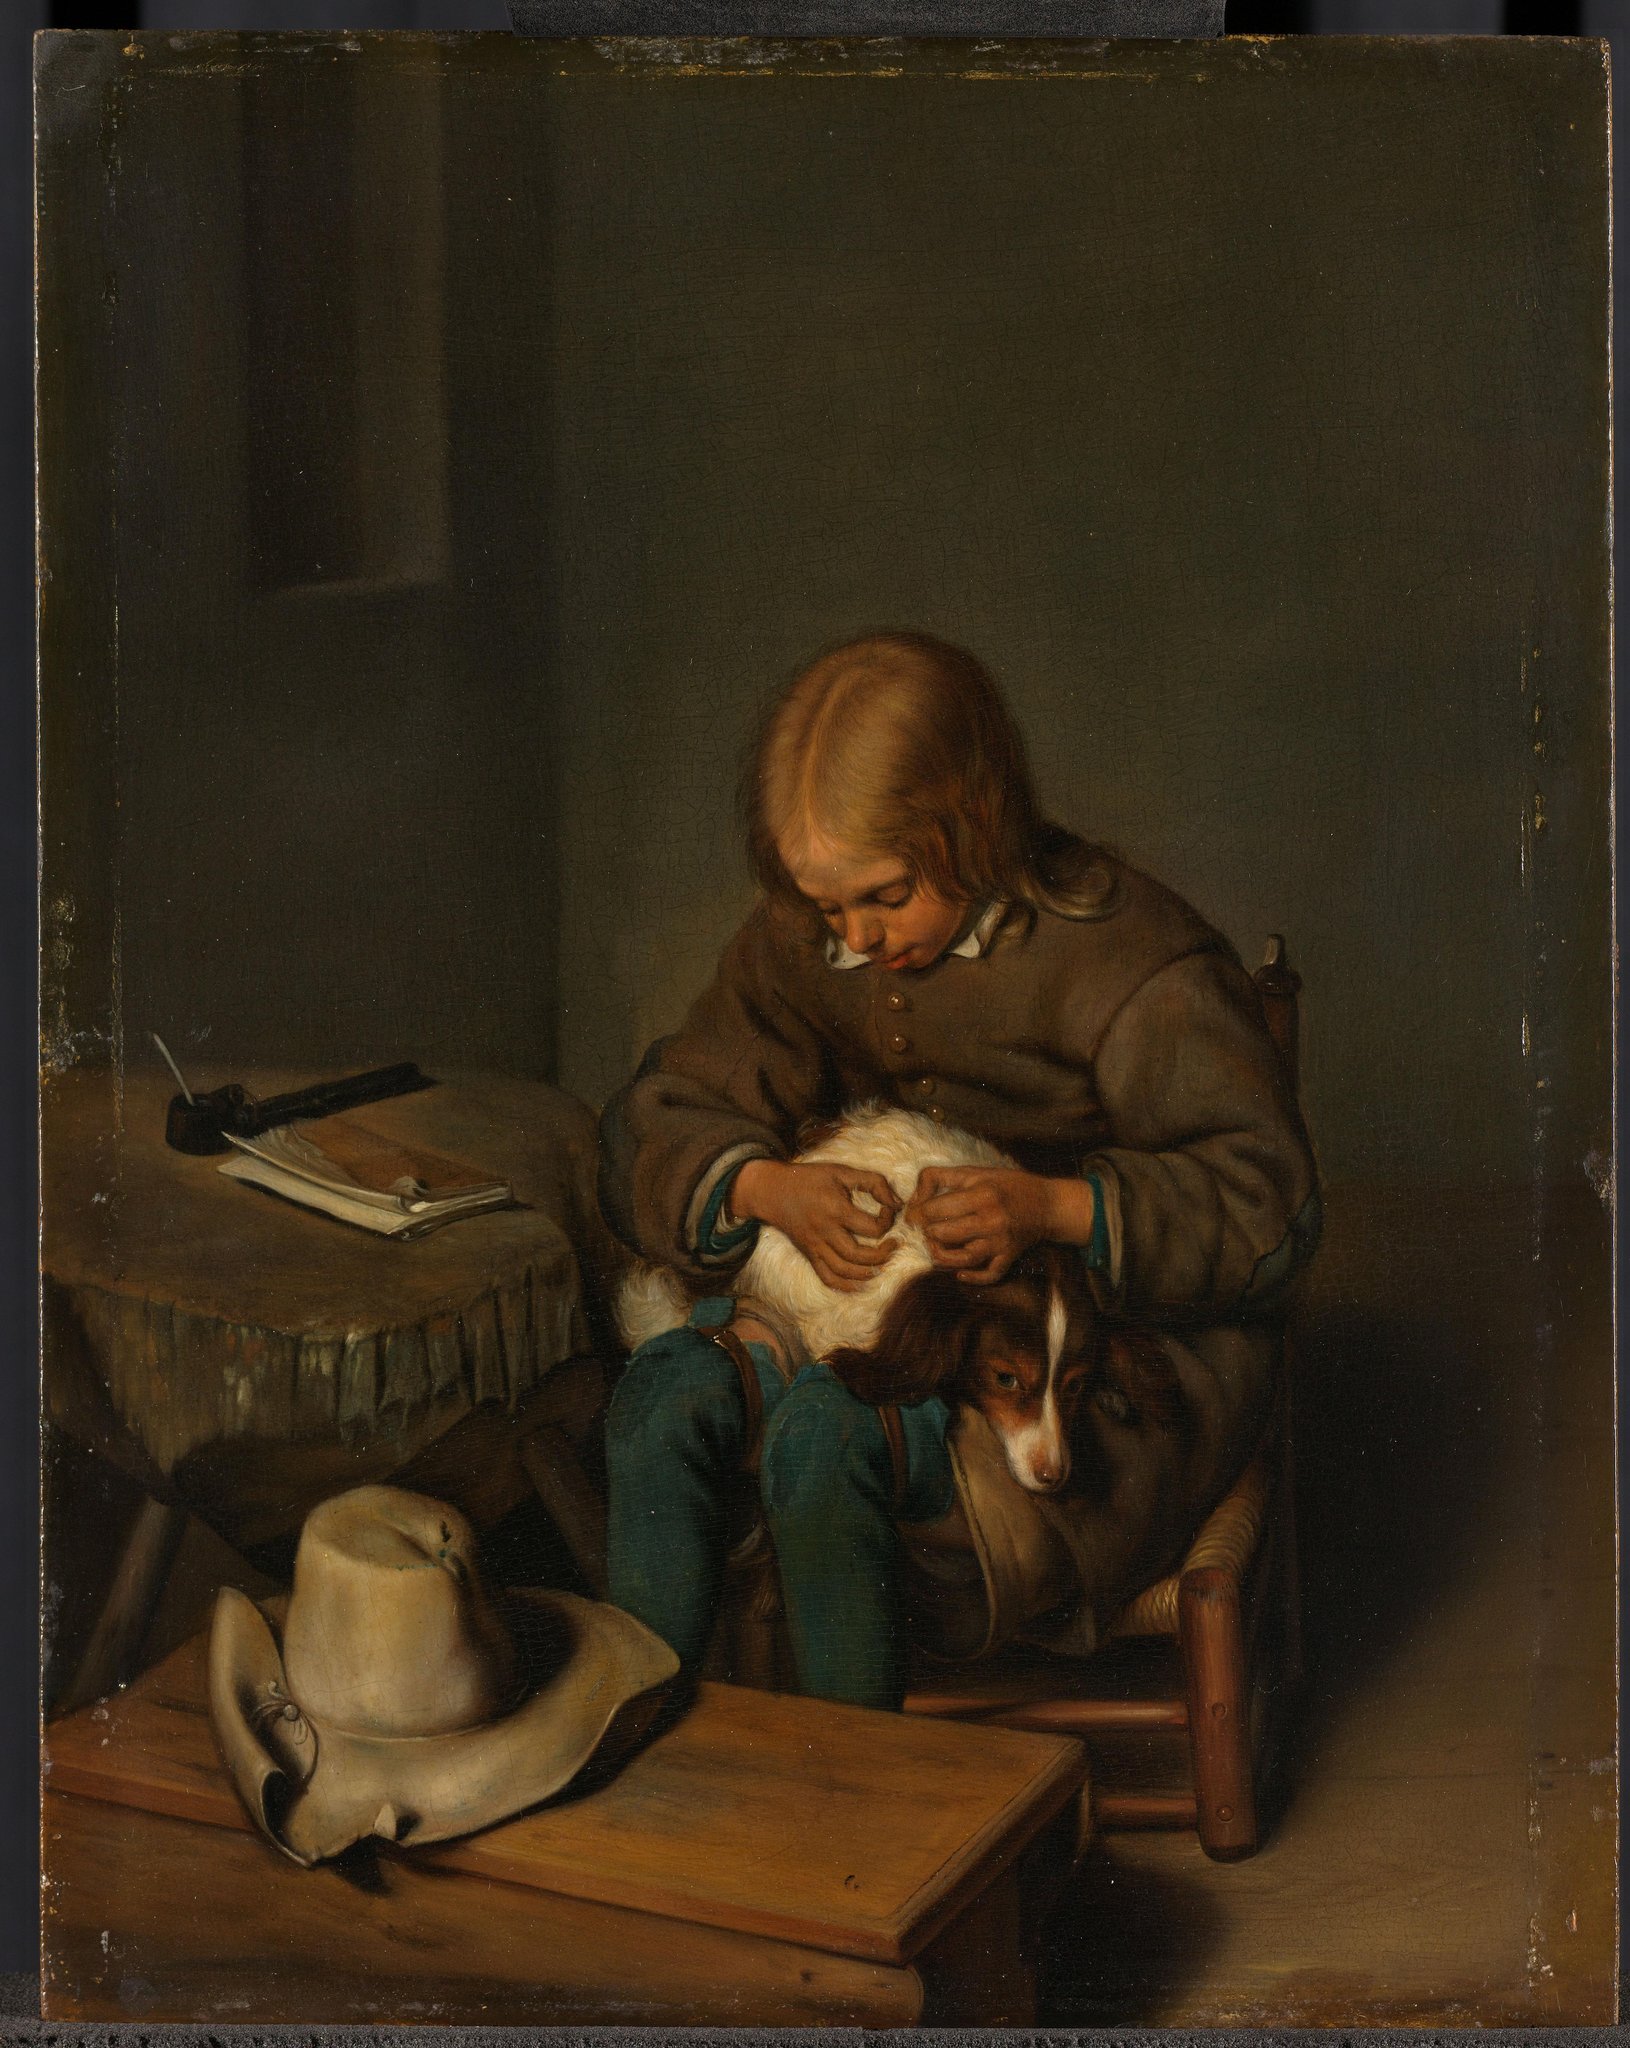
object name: painting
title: Boy Fleaing a Dog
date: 1728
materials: oil, panel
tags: looking for fleas, dog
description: Jongen bezig een hondje te vlooien. De jongen zit op een stoeltje met de hond op schoot. Op een tafel rechts een boek en pen. Op een houten bankje ligt de hoed van de jongen.